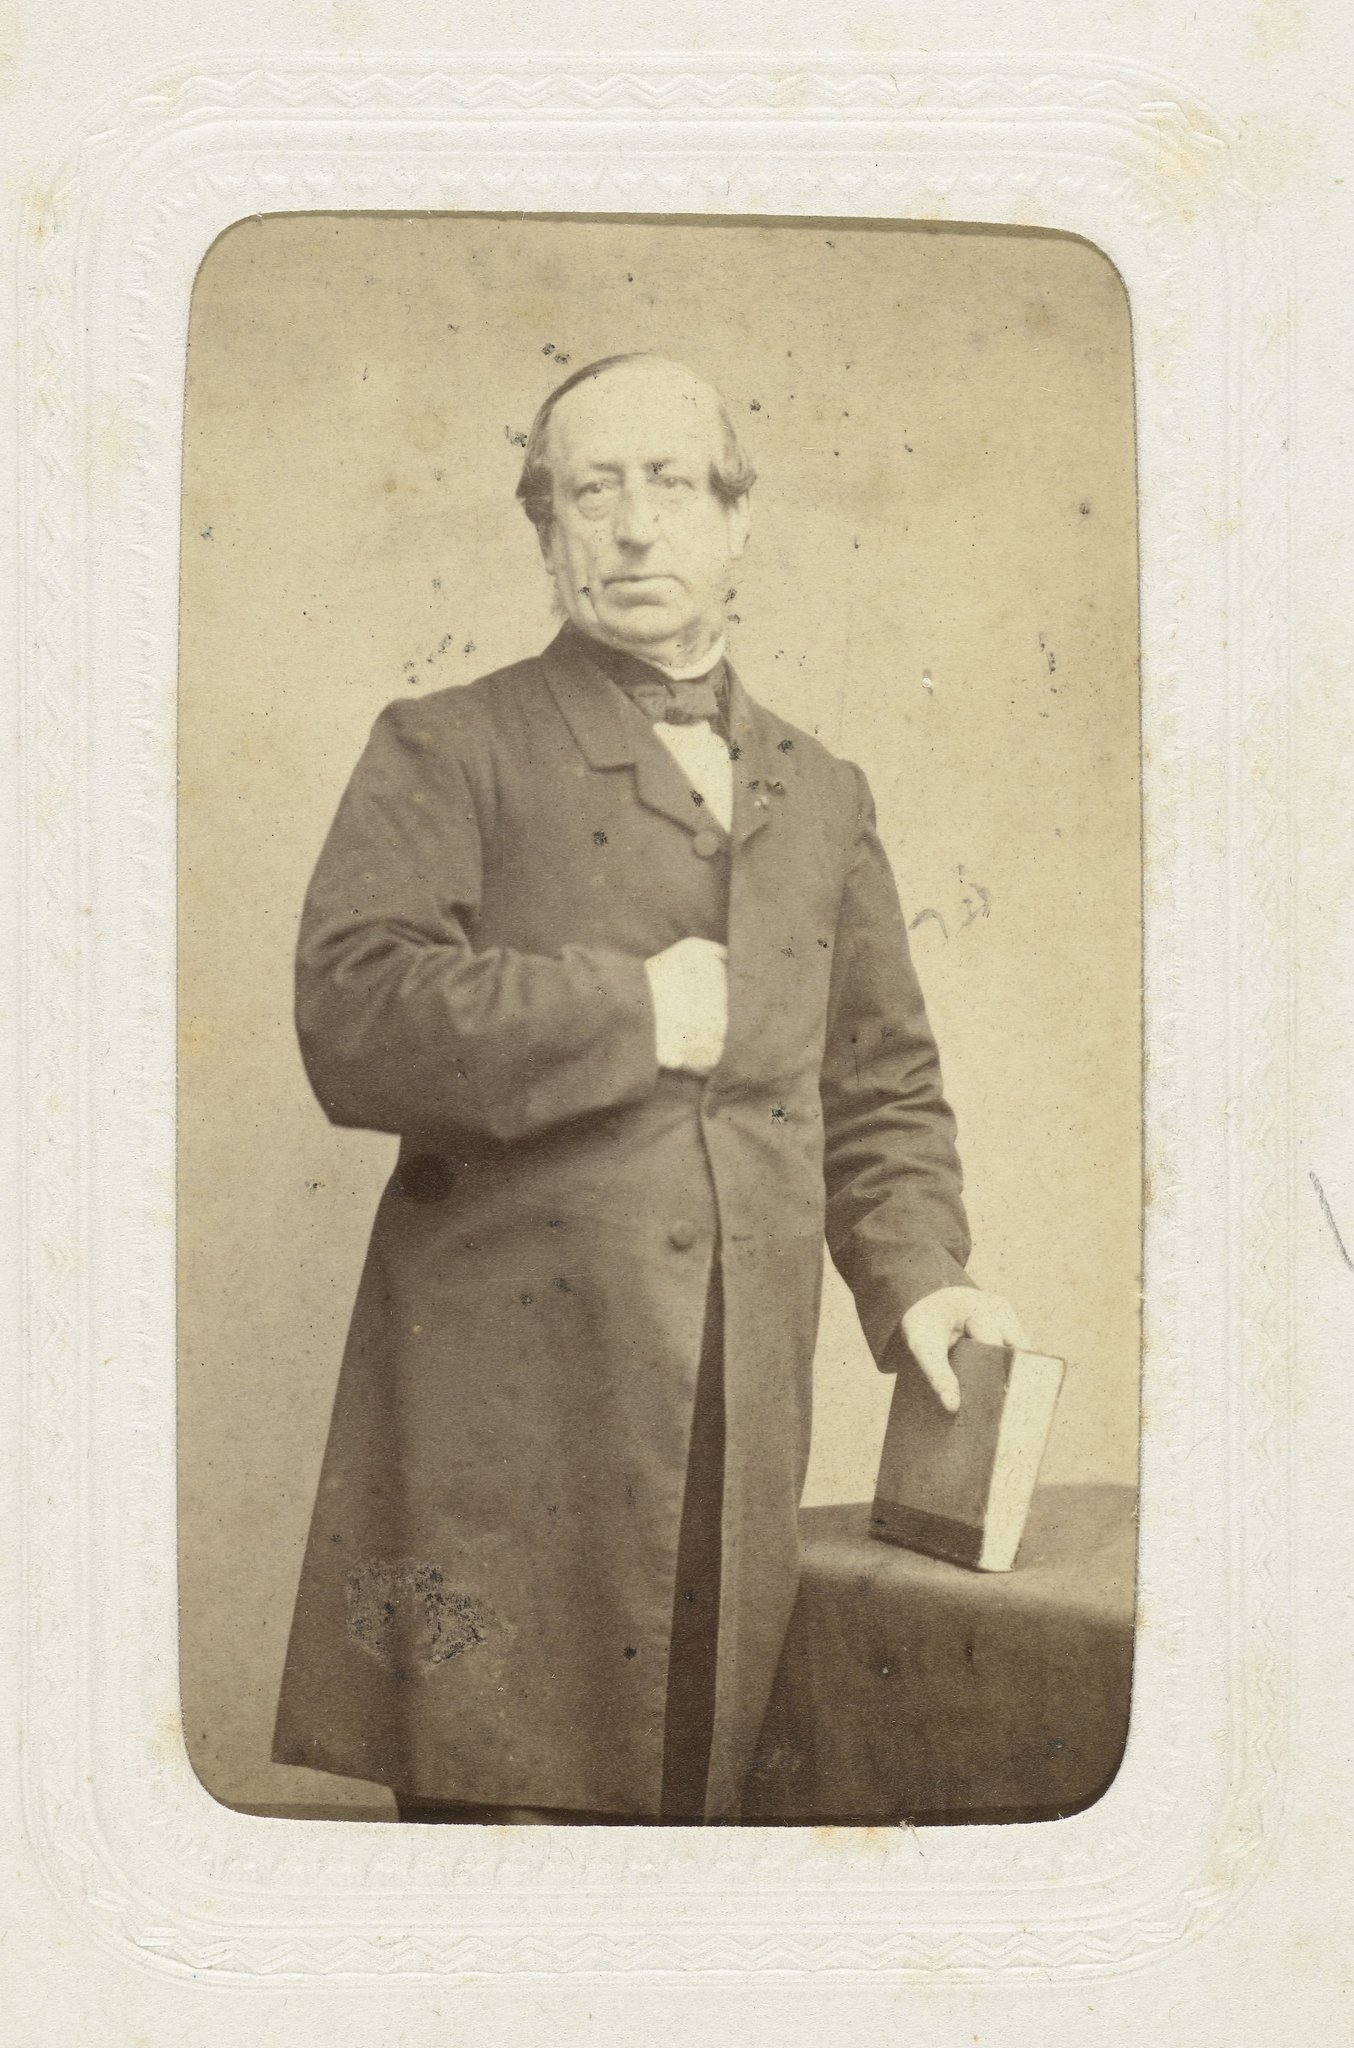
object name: carte de visite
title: Portret van Prof. Dr. Jan van Geuns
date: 1863-1866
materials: cardboard, paper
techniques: albumen print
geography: amsterdam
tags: hoogleraar, jan van geuns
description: Zie ook: Stadsarchief Gemeente Amsterdam [http://beeldbank.amsterdam.nl/beeldbank/weergave/record/?id=010097008465] en het Album Academicum van de Universiteit van Amsterdam [http://albumacademicum.uva.nl/].